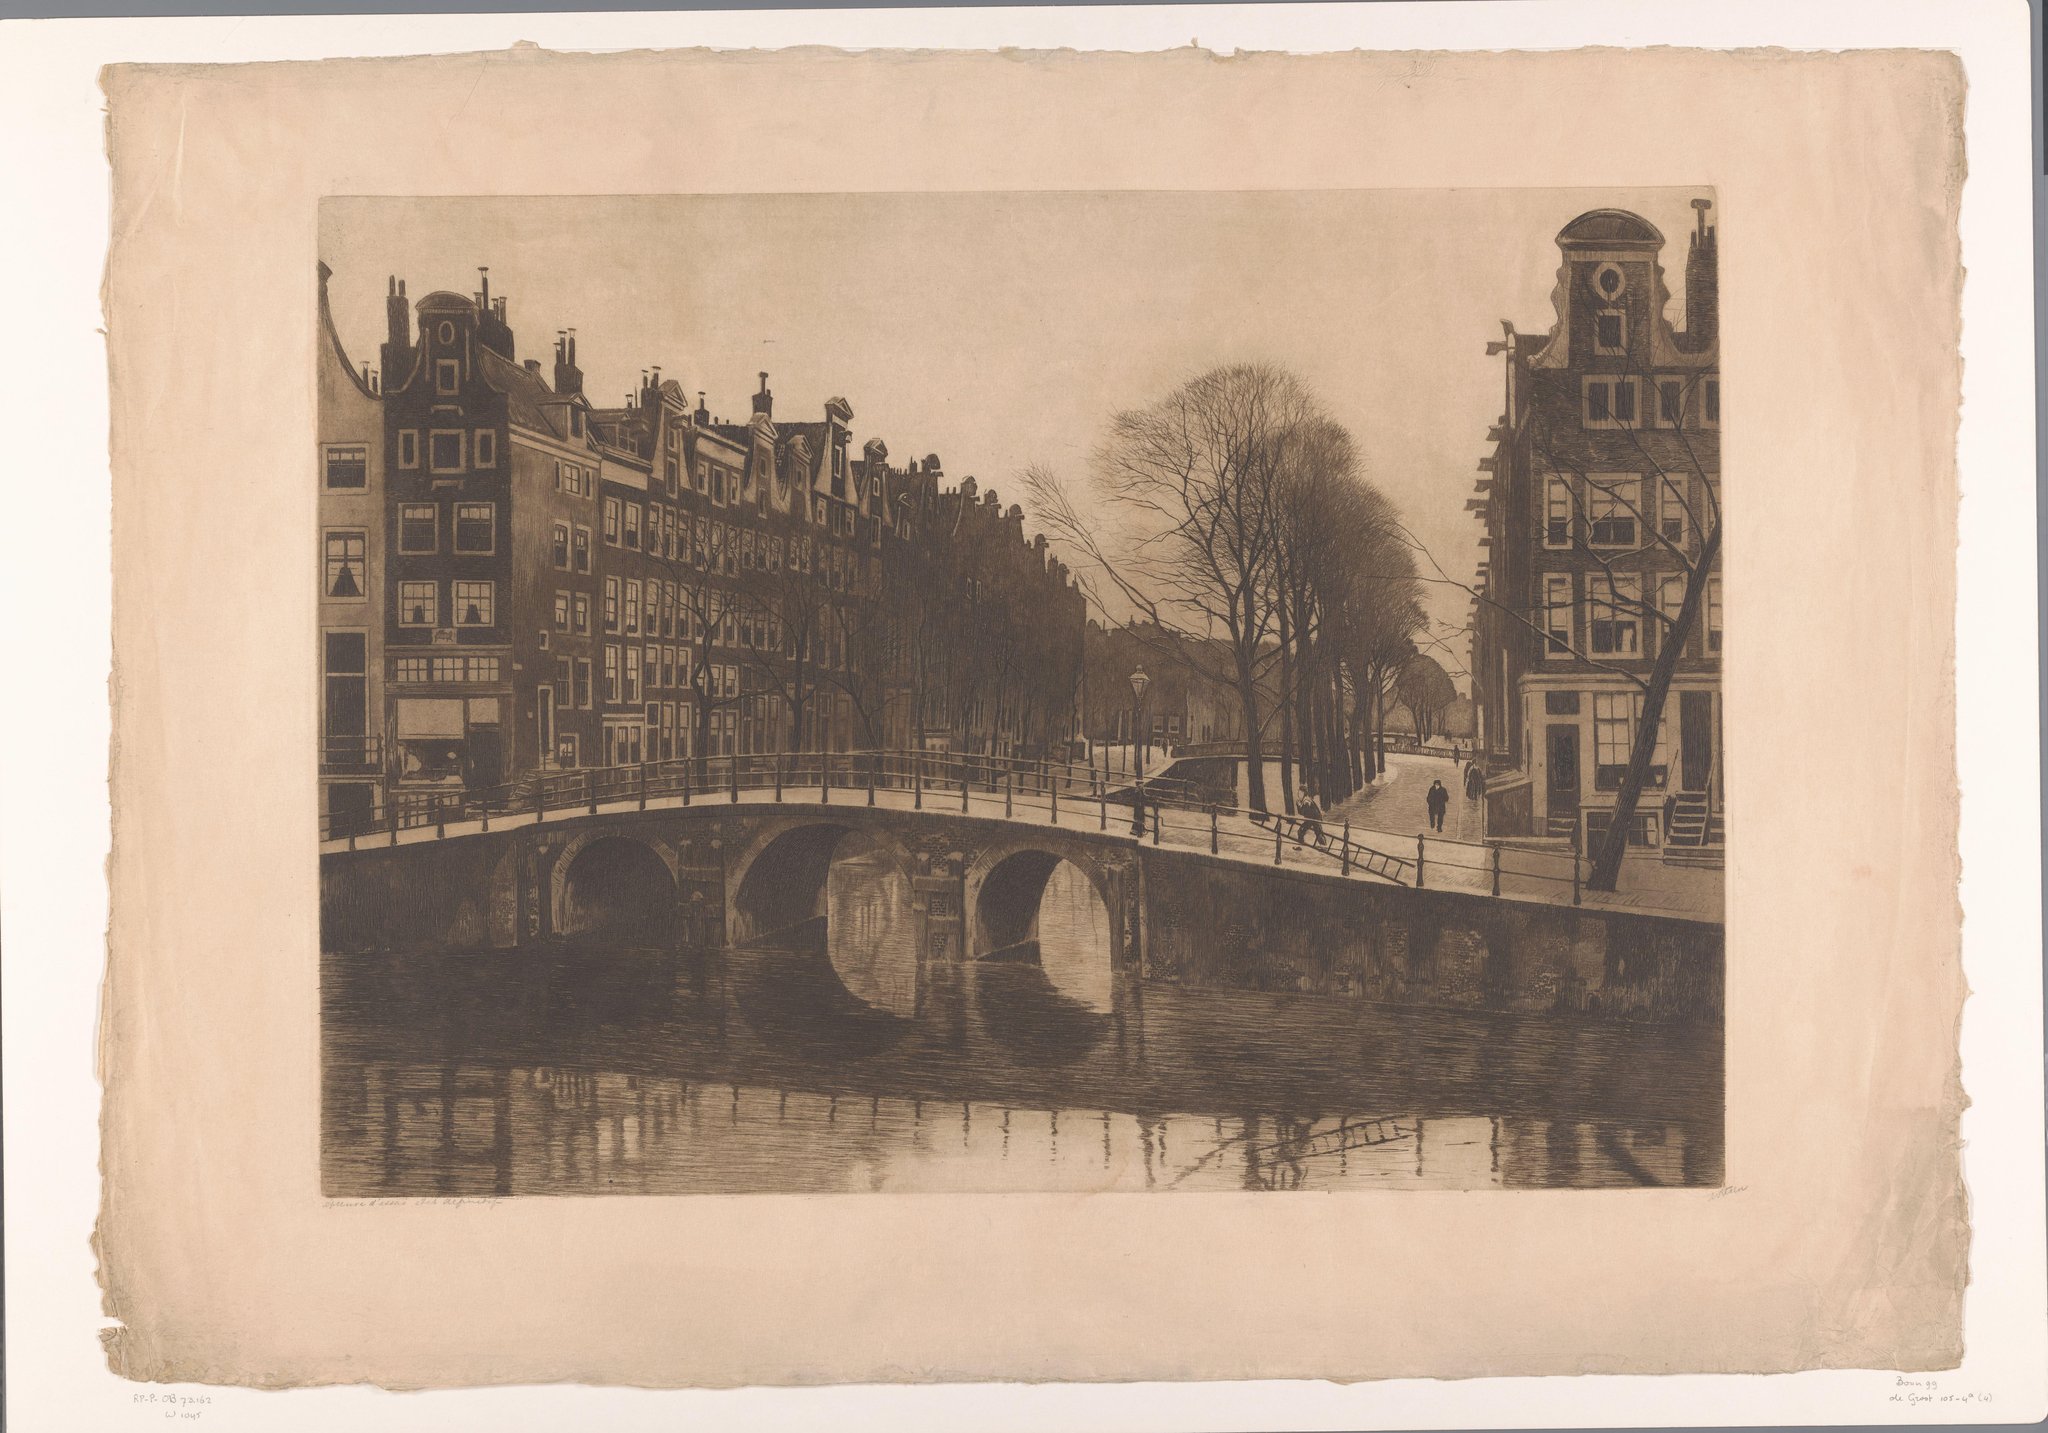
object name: print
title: Leidsegracht te Amsterdam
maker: willem witsen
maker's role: draughtsman, painter, print maker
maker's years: 1860-1923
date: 1901-1902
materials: paper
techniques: aquatint, etching, intaglio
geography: netherlands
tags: canals, waters (in city)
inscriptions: collector's mark: Lugt 2228